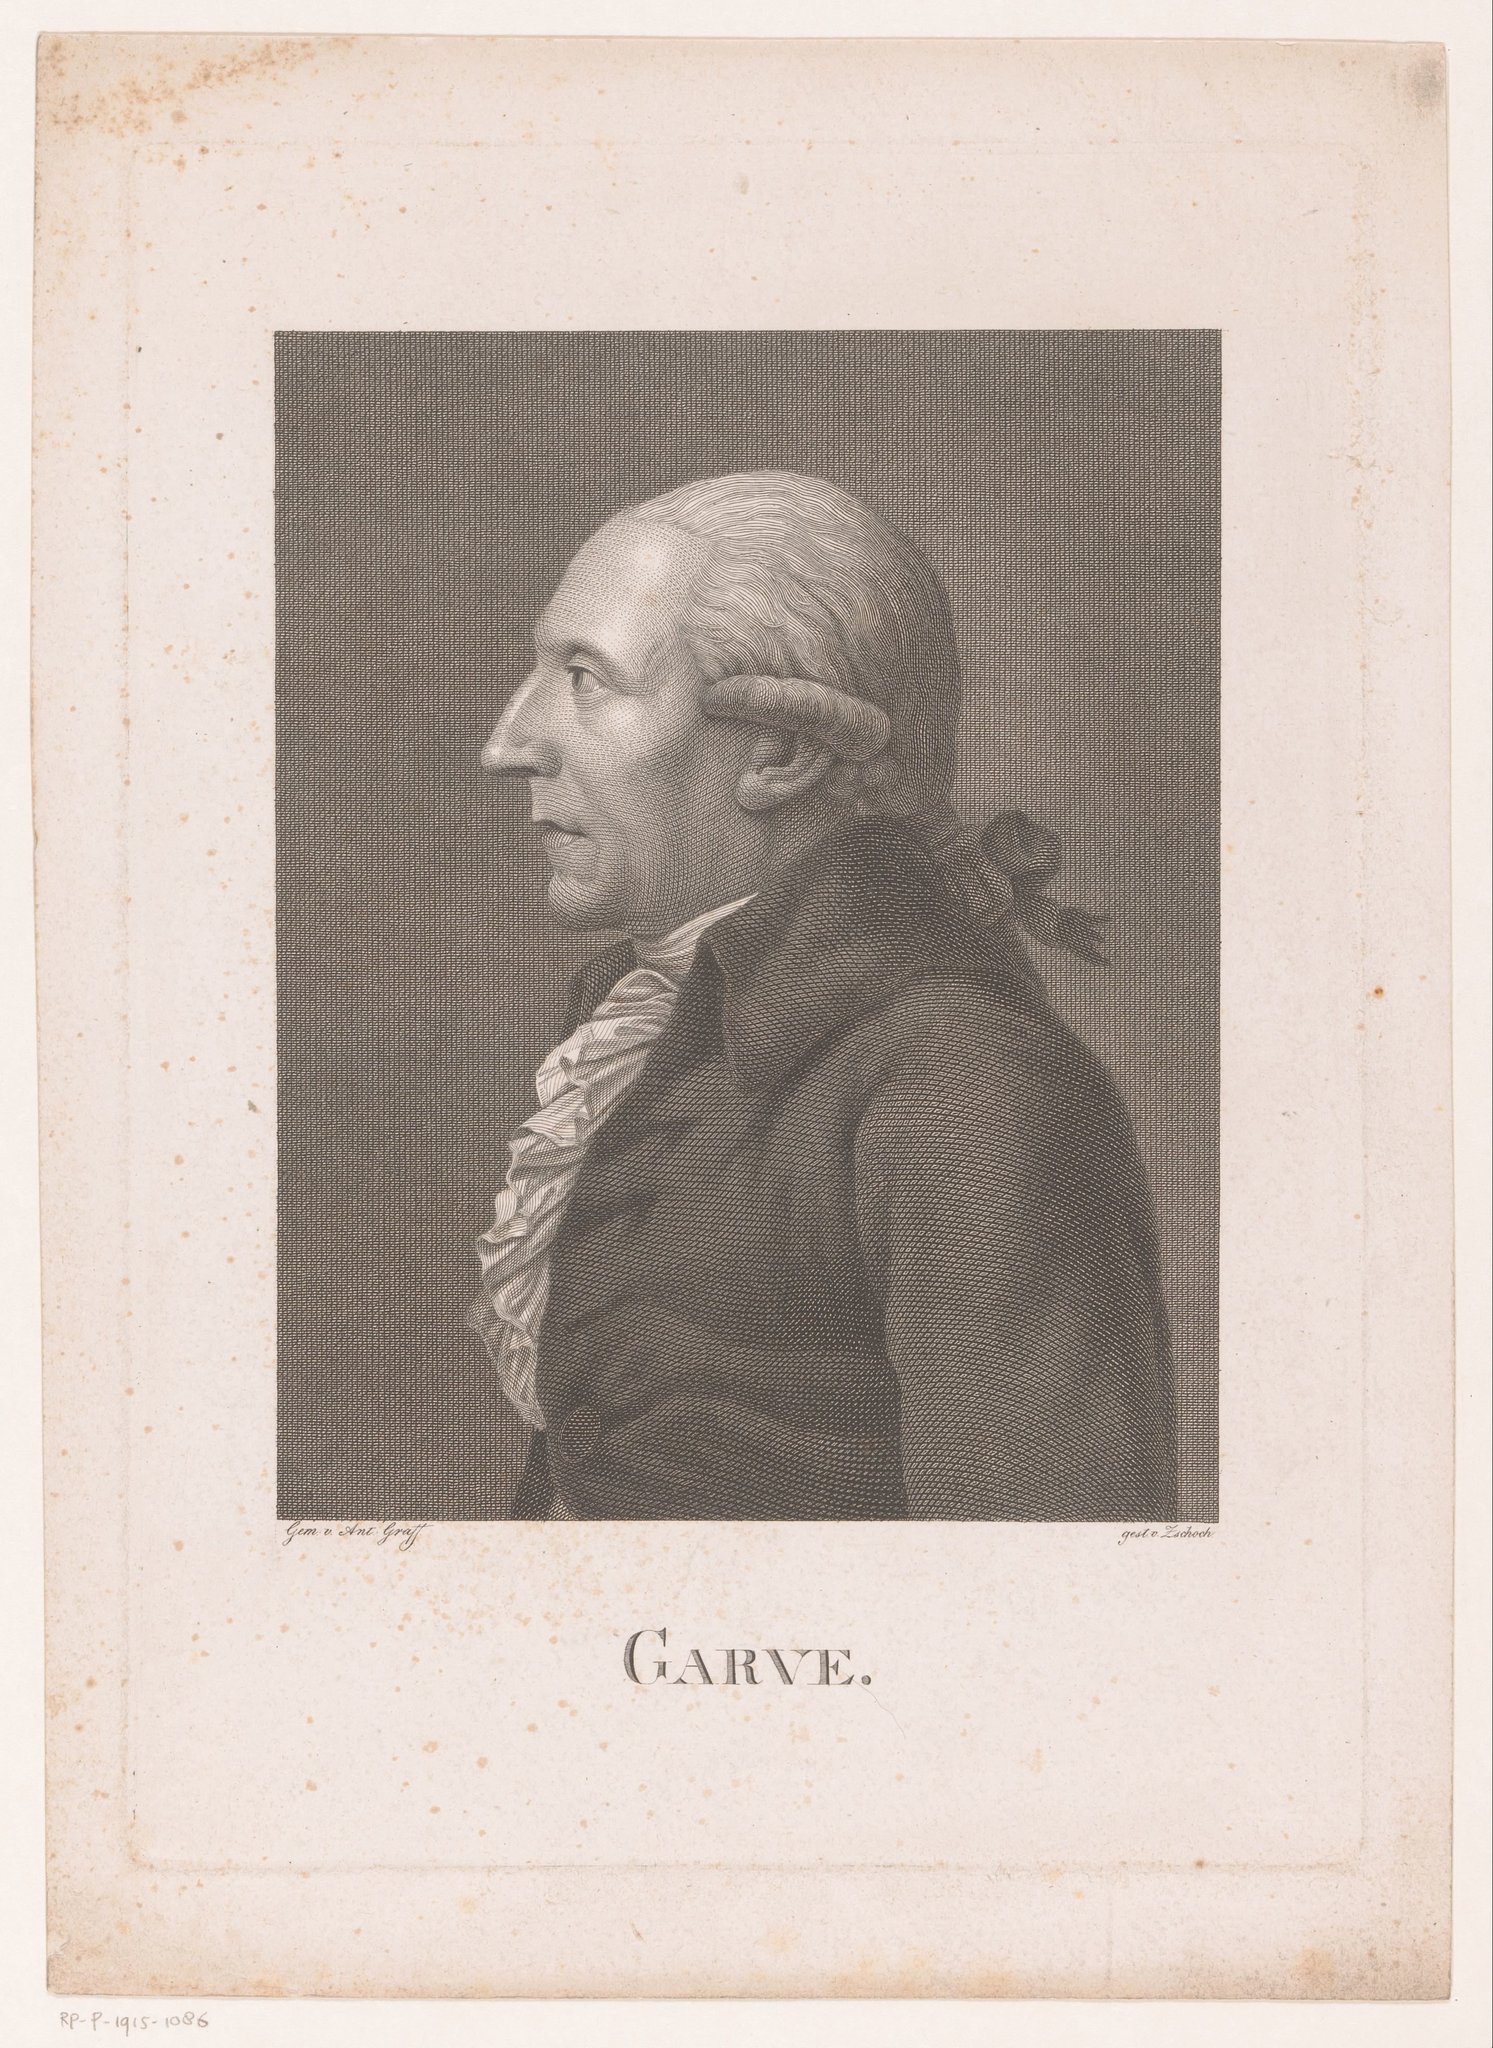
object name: print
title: Portret van Christian Garve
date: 1785-1833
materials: paper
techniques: etching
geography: germany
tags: historical persons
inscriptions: collector's mark: Lugt 2228